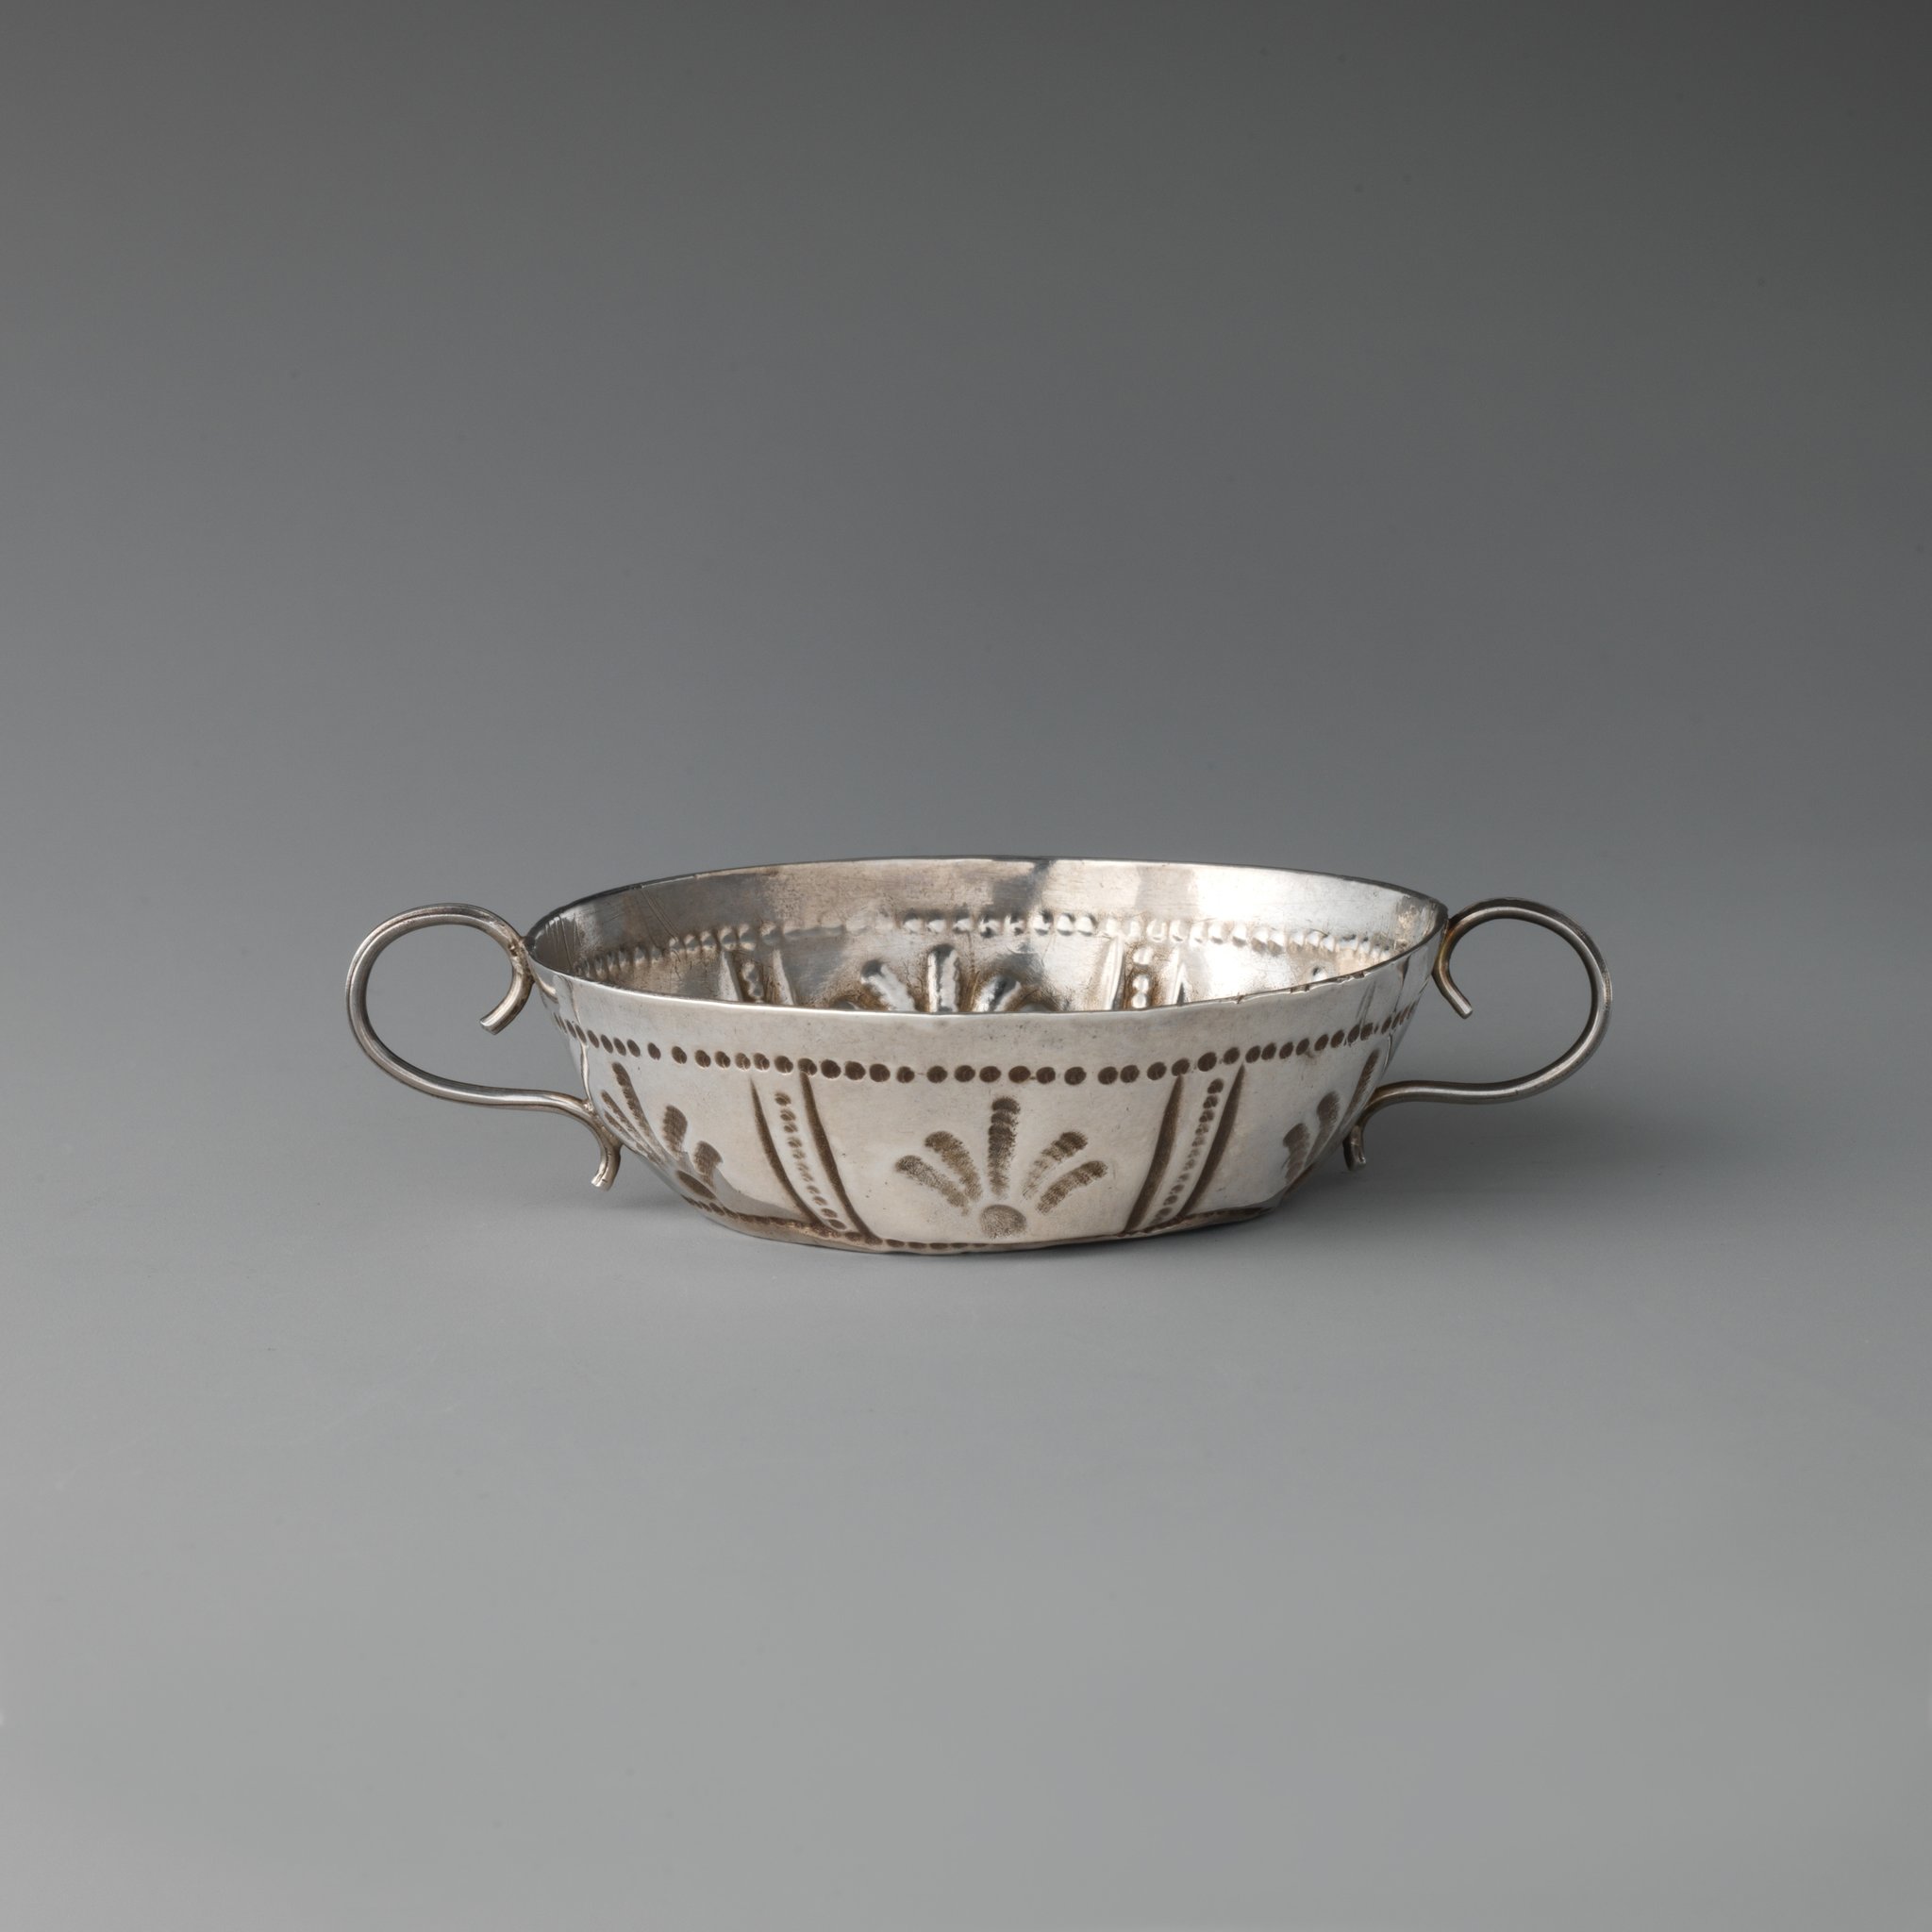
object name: wine taster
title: Miniature wine taster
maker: w. m.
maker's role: maker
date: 1670-1675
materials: silver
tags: flowers